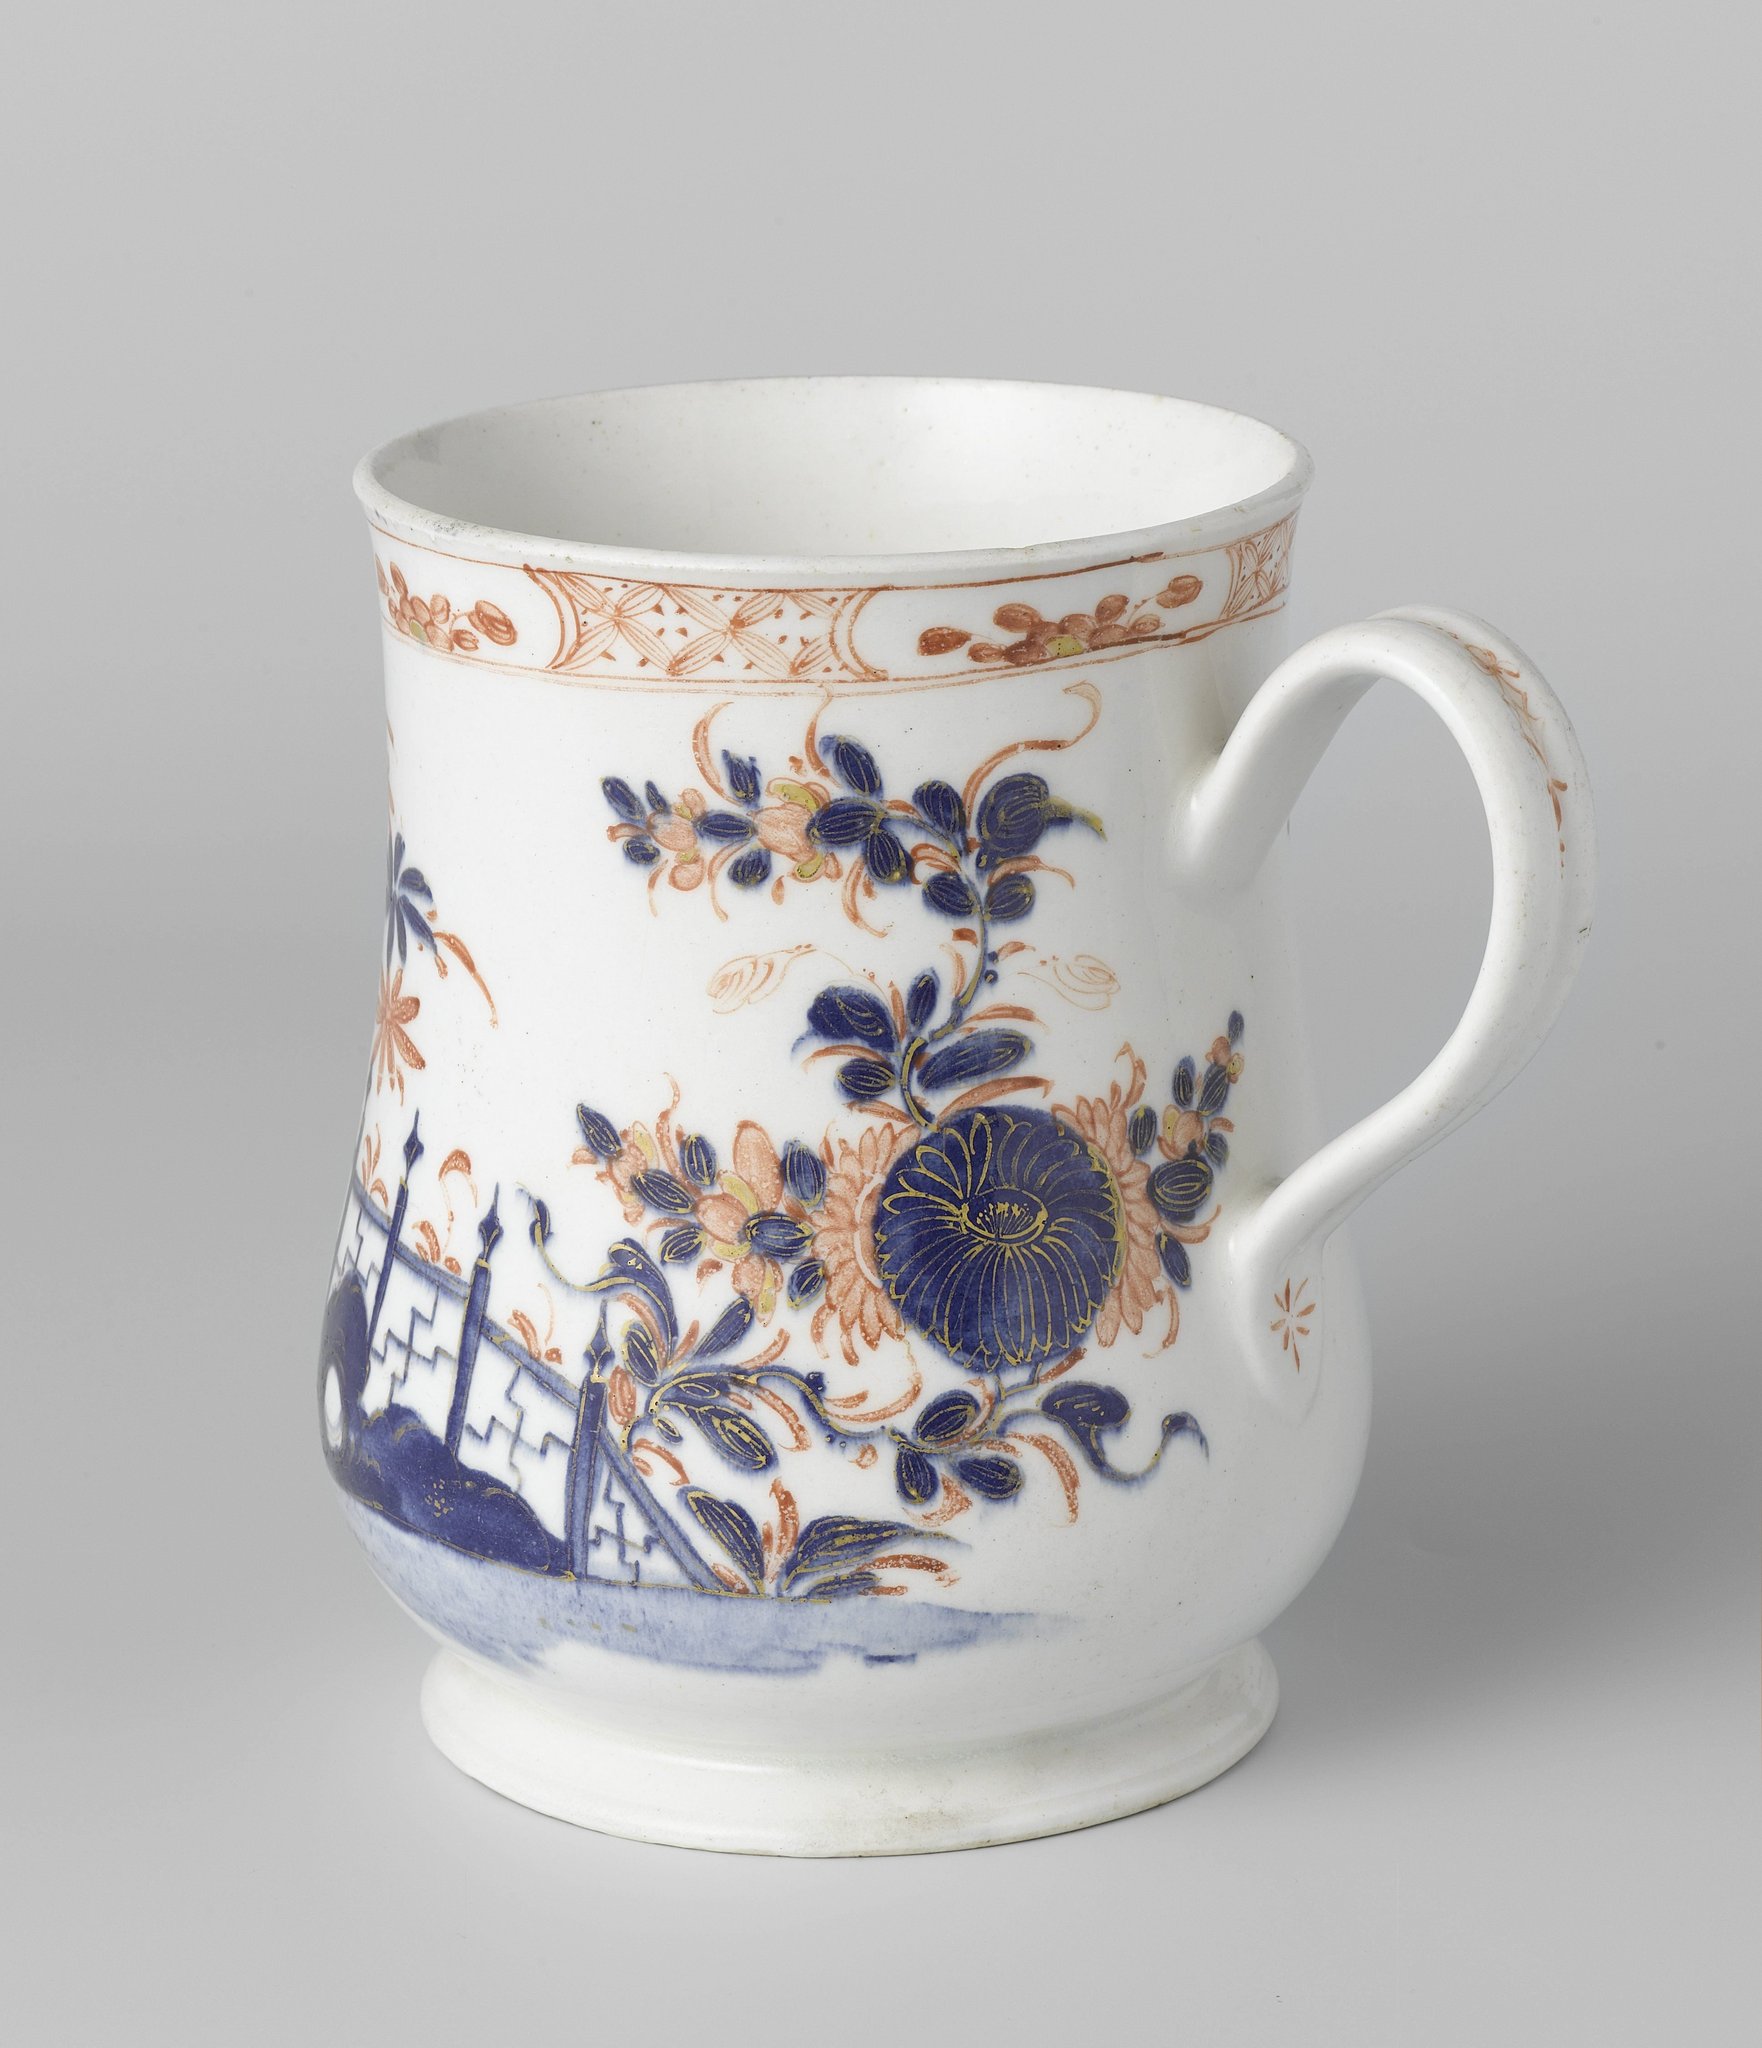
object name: cup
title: Beker met oor, iets uitgebuikt model, versierd met een Japanse tuin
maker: Anonymous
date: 1790-1800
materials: soft paste porcelain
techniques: painted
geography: bow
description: Beker met oor, van porselein. Iets uitgebuikt model, versierd met een Japanse tuin in rood, blauw en goud. Langs de mondrand een versiering van geometrische figuren, waartussen perken met bladornament. Op het oor enkele geometrische figuren in rood.